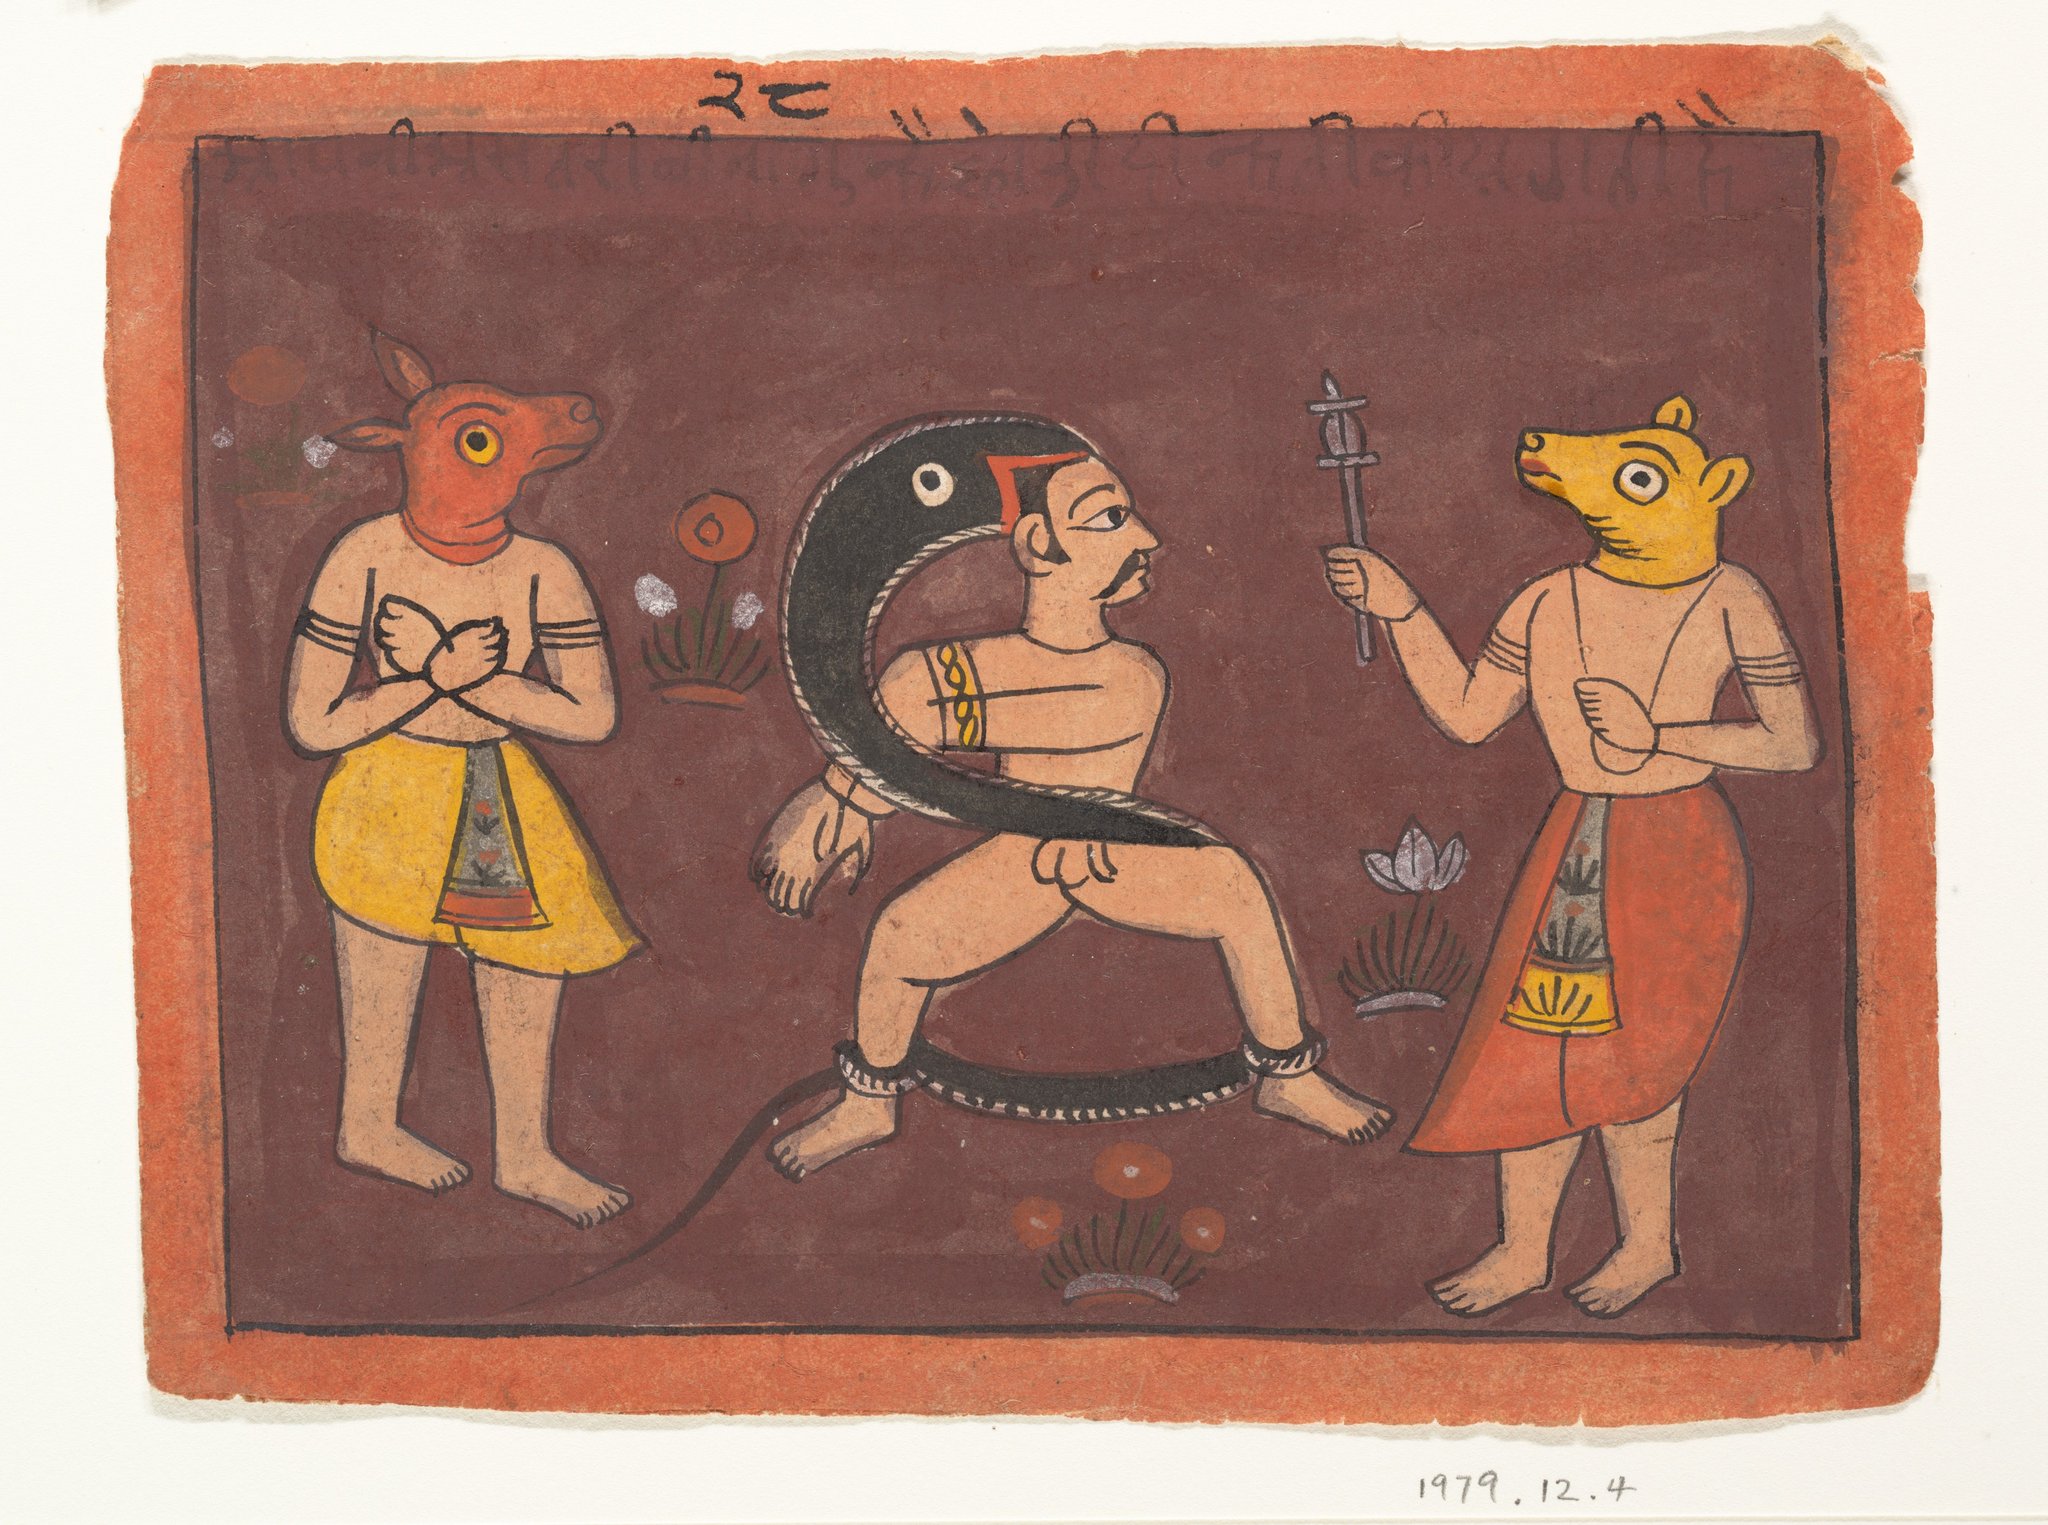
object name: painting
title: Folk Painting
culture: indian, rajasthan, marwar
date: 1725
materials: ink, paper, watercolor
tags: men,mythical creatures